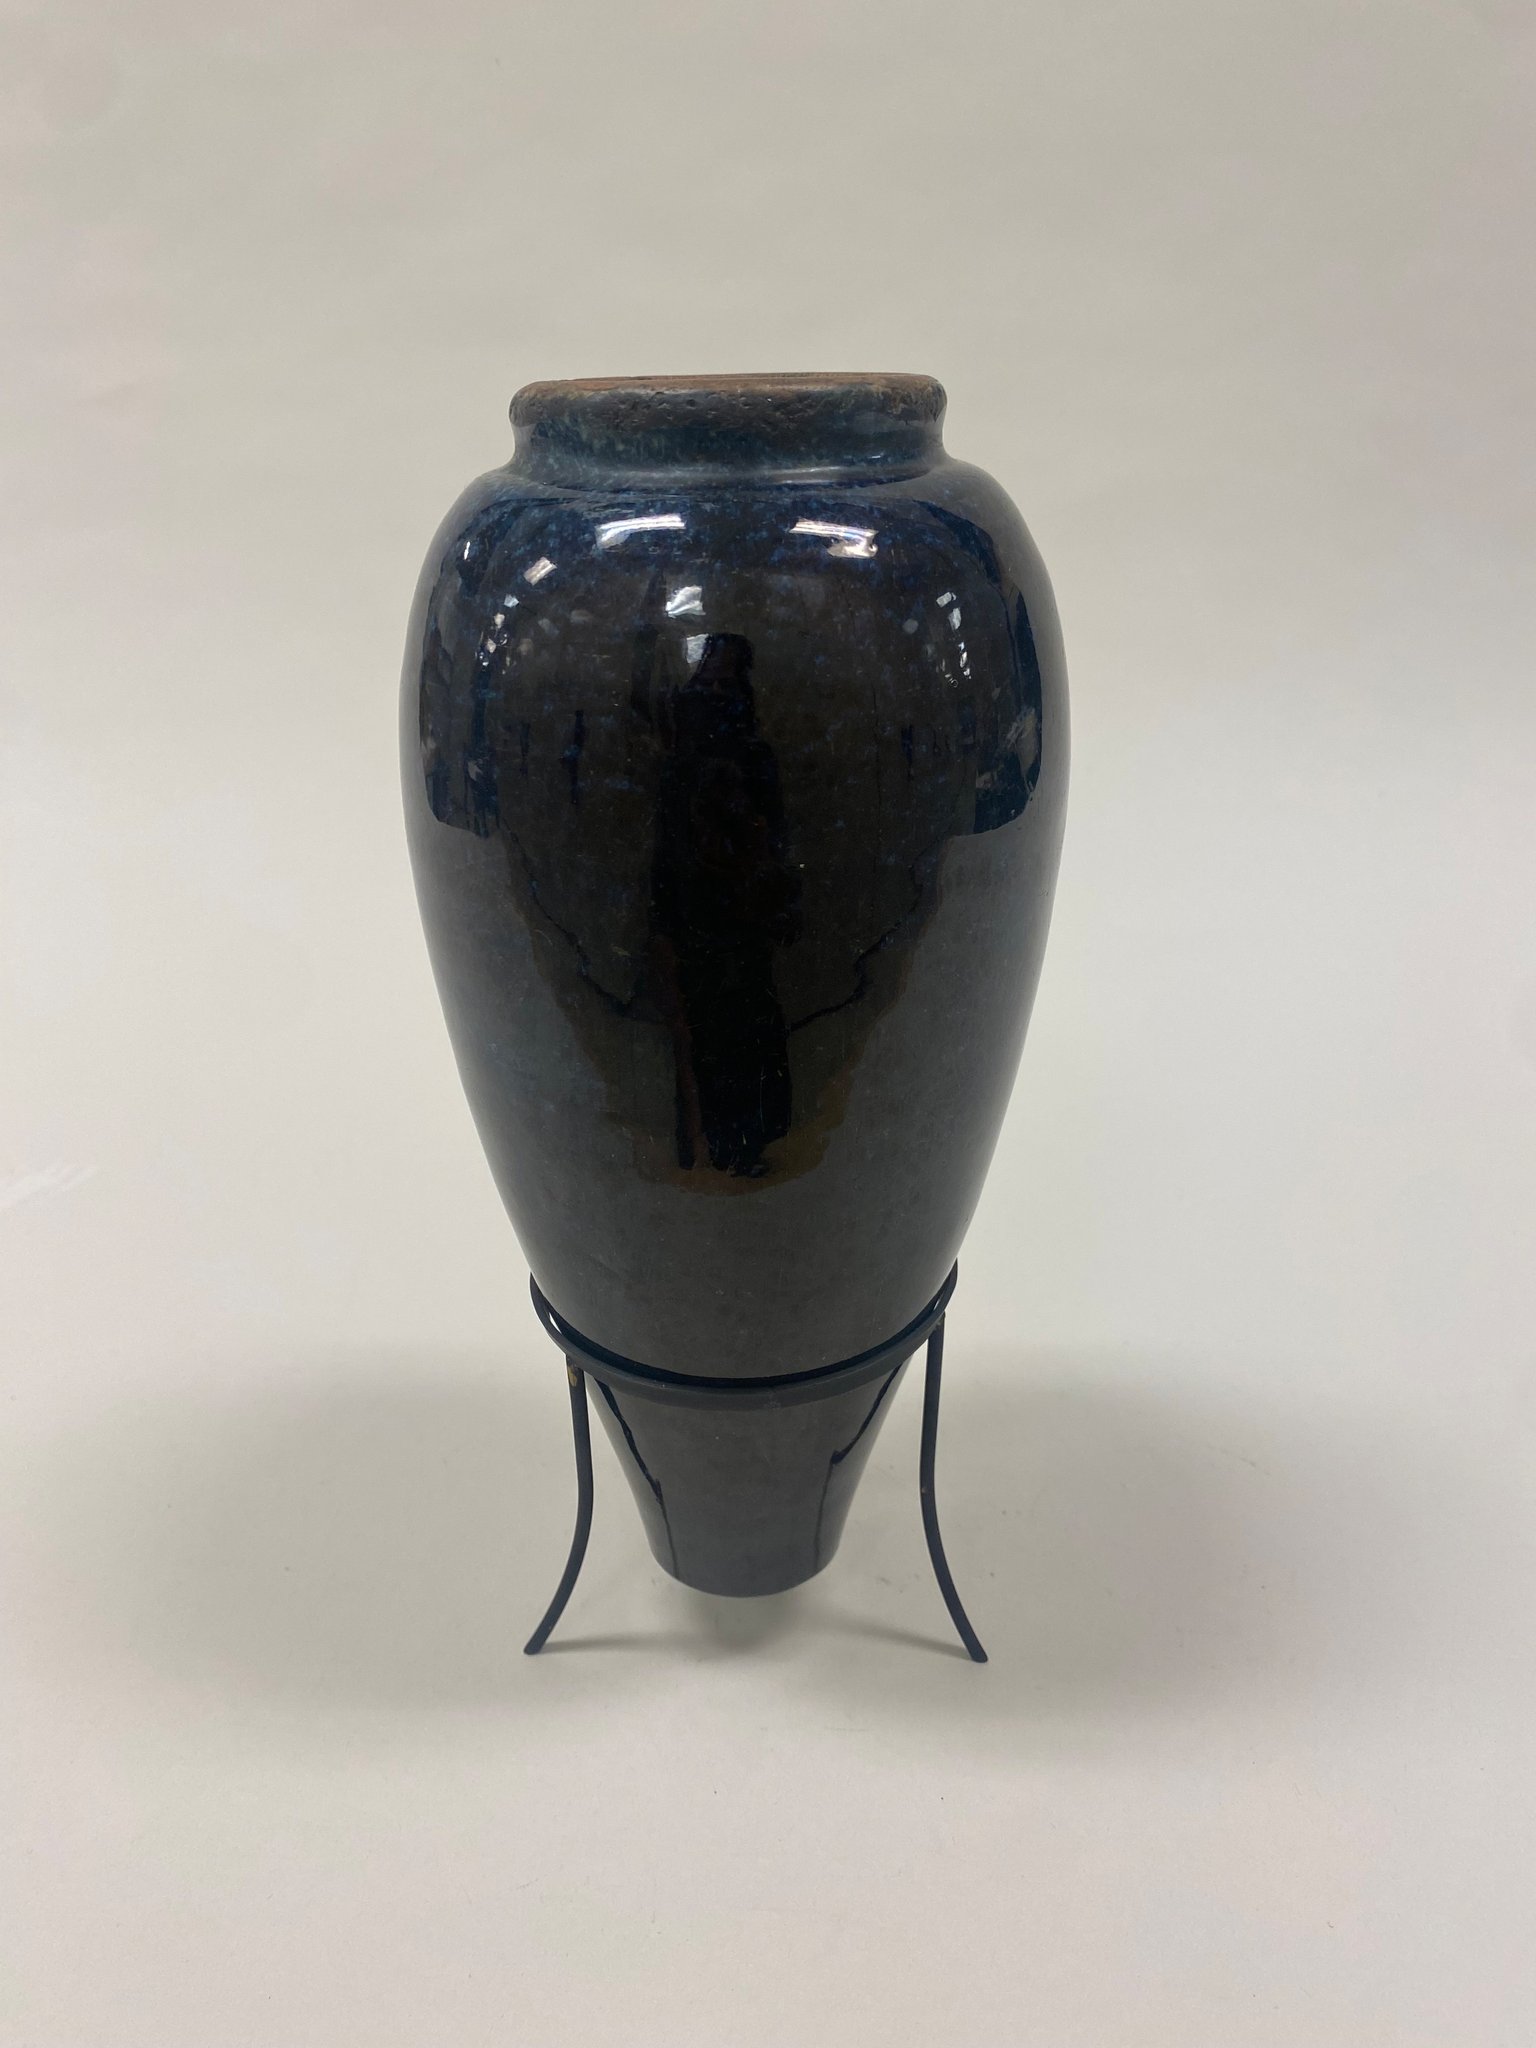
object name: bottle vase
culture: chinese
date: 1801-1900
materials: glaze, stoneware